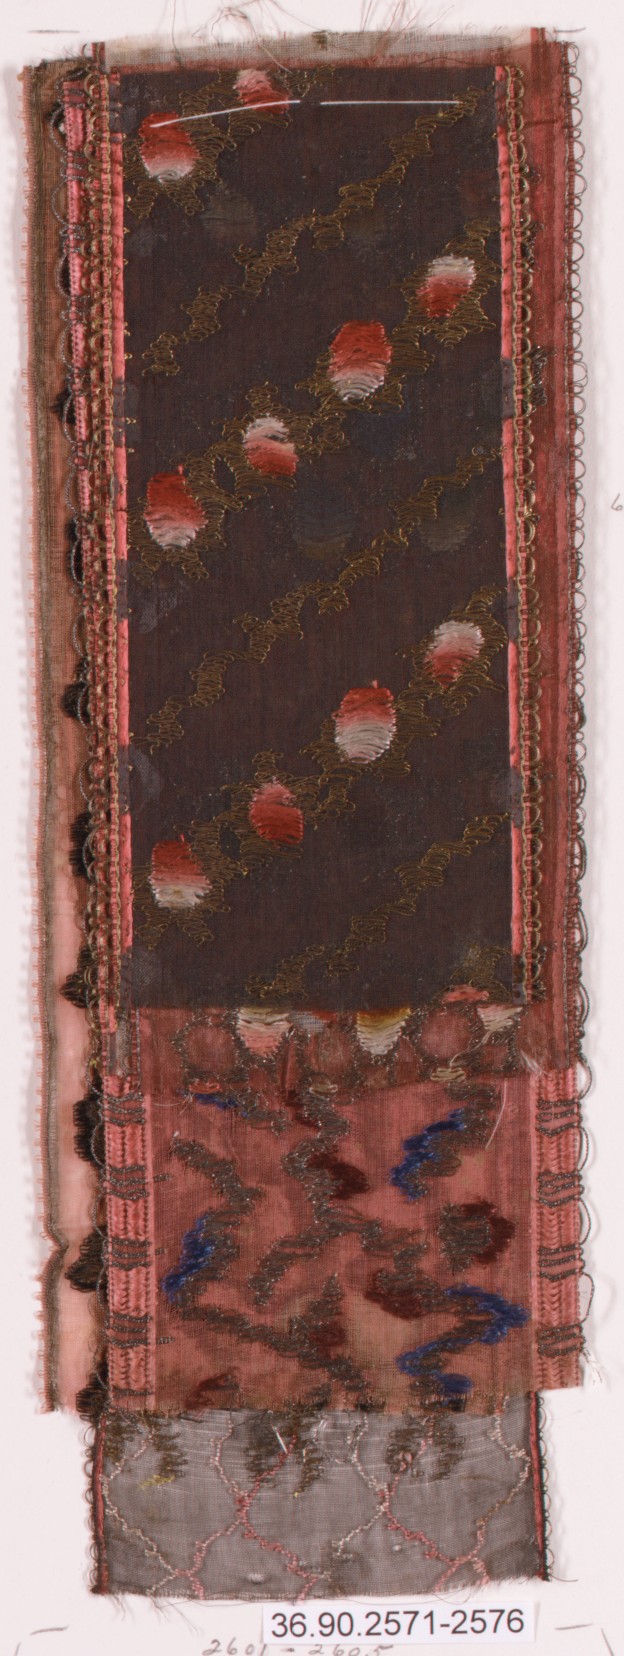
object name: ribbon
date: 1801-1900